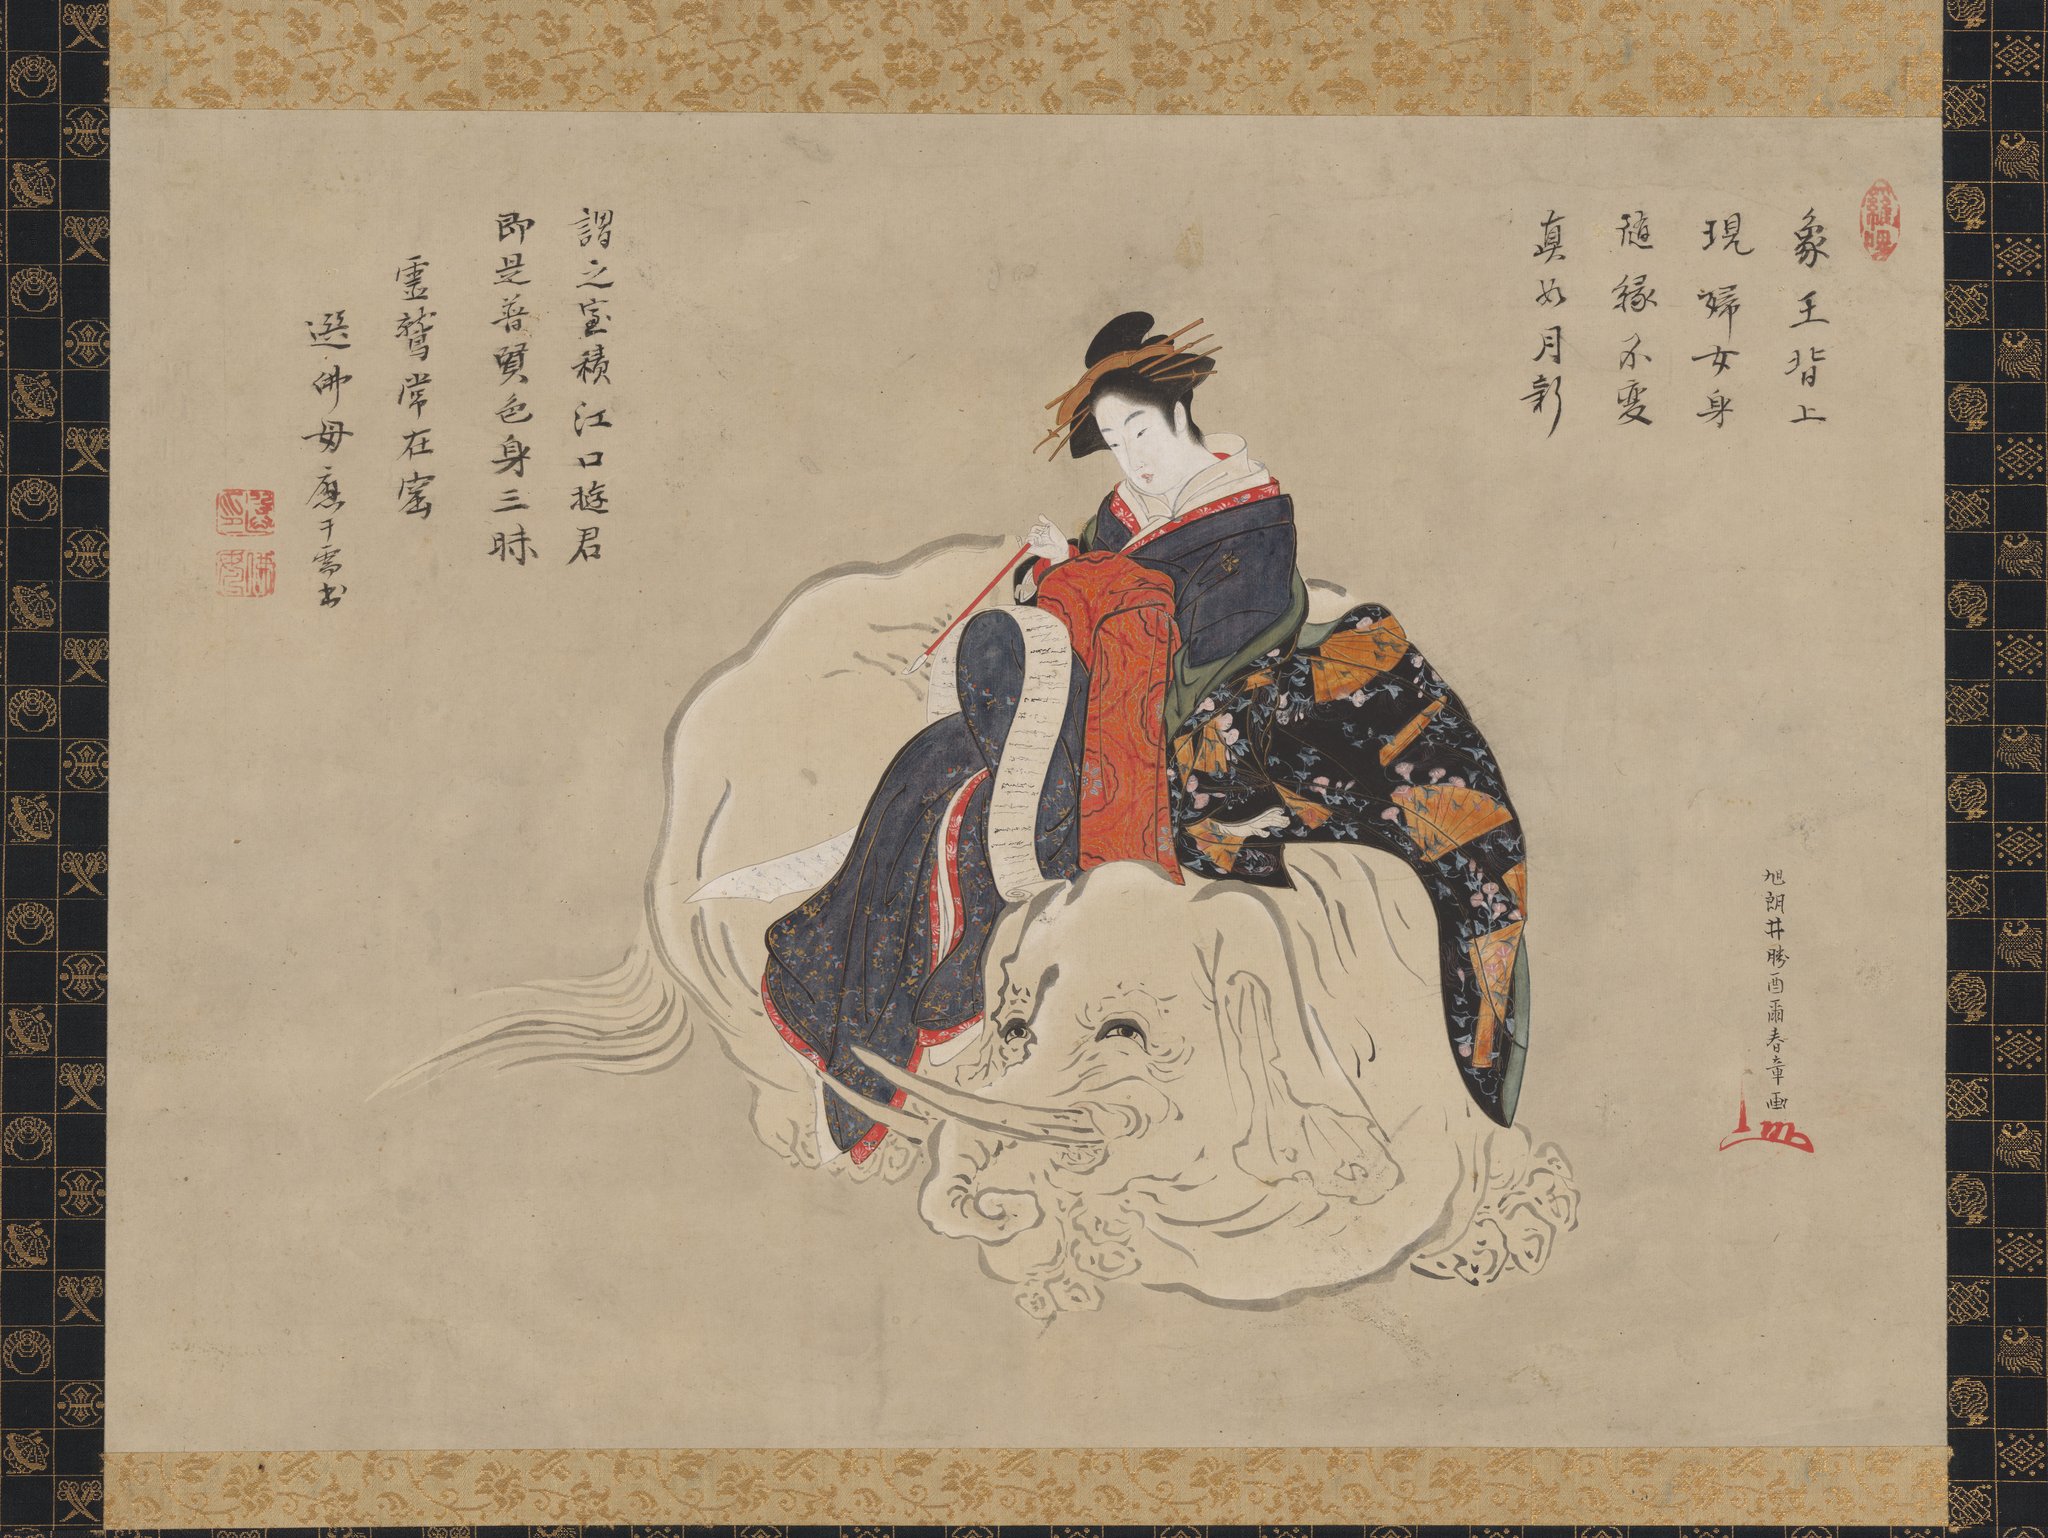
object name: hanging scroll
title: Courtesan of Eguchi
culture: japanese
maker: katsukawa shunshō 勝川春章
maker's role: artist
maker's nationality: japanese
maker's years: 1726-1792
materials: ink, paper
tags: women,elephants